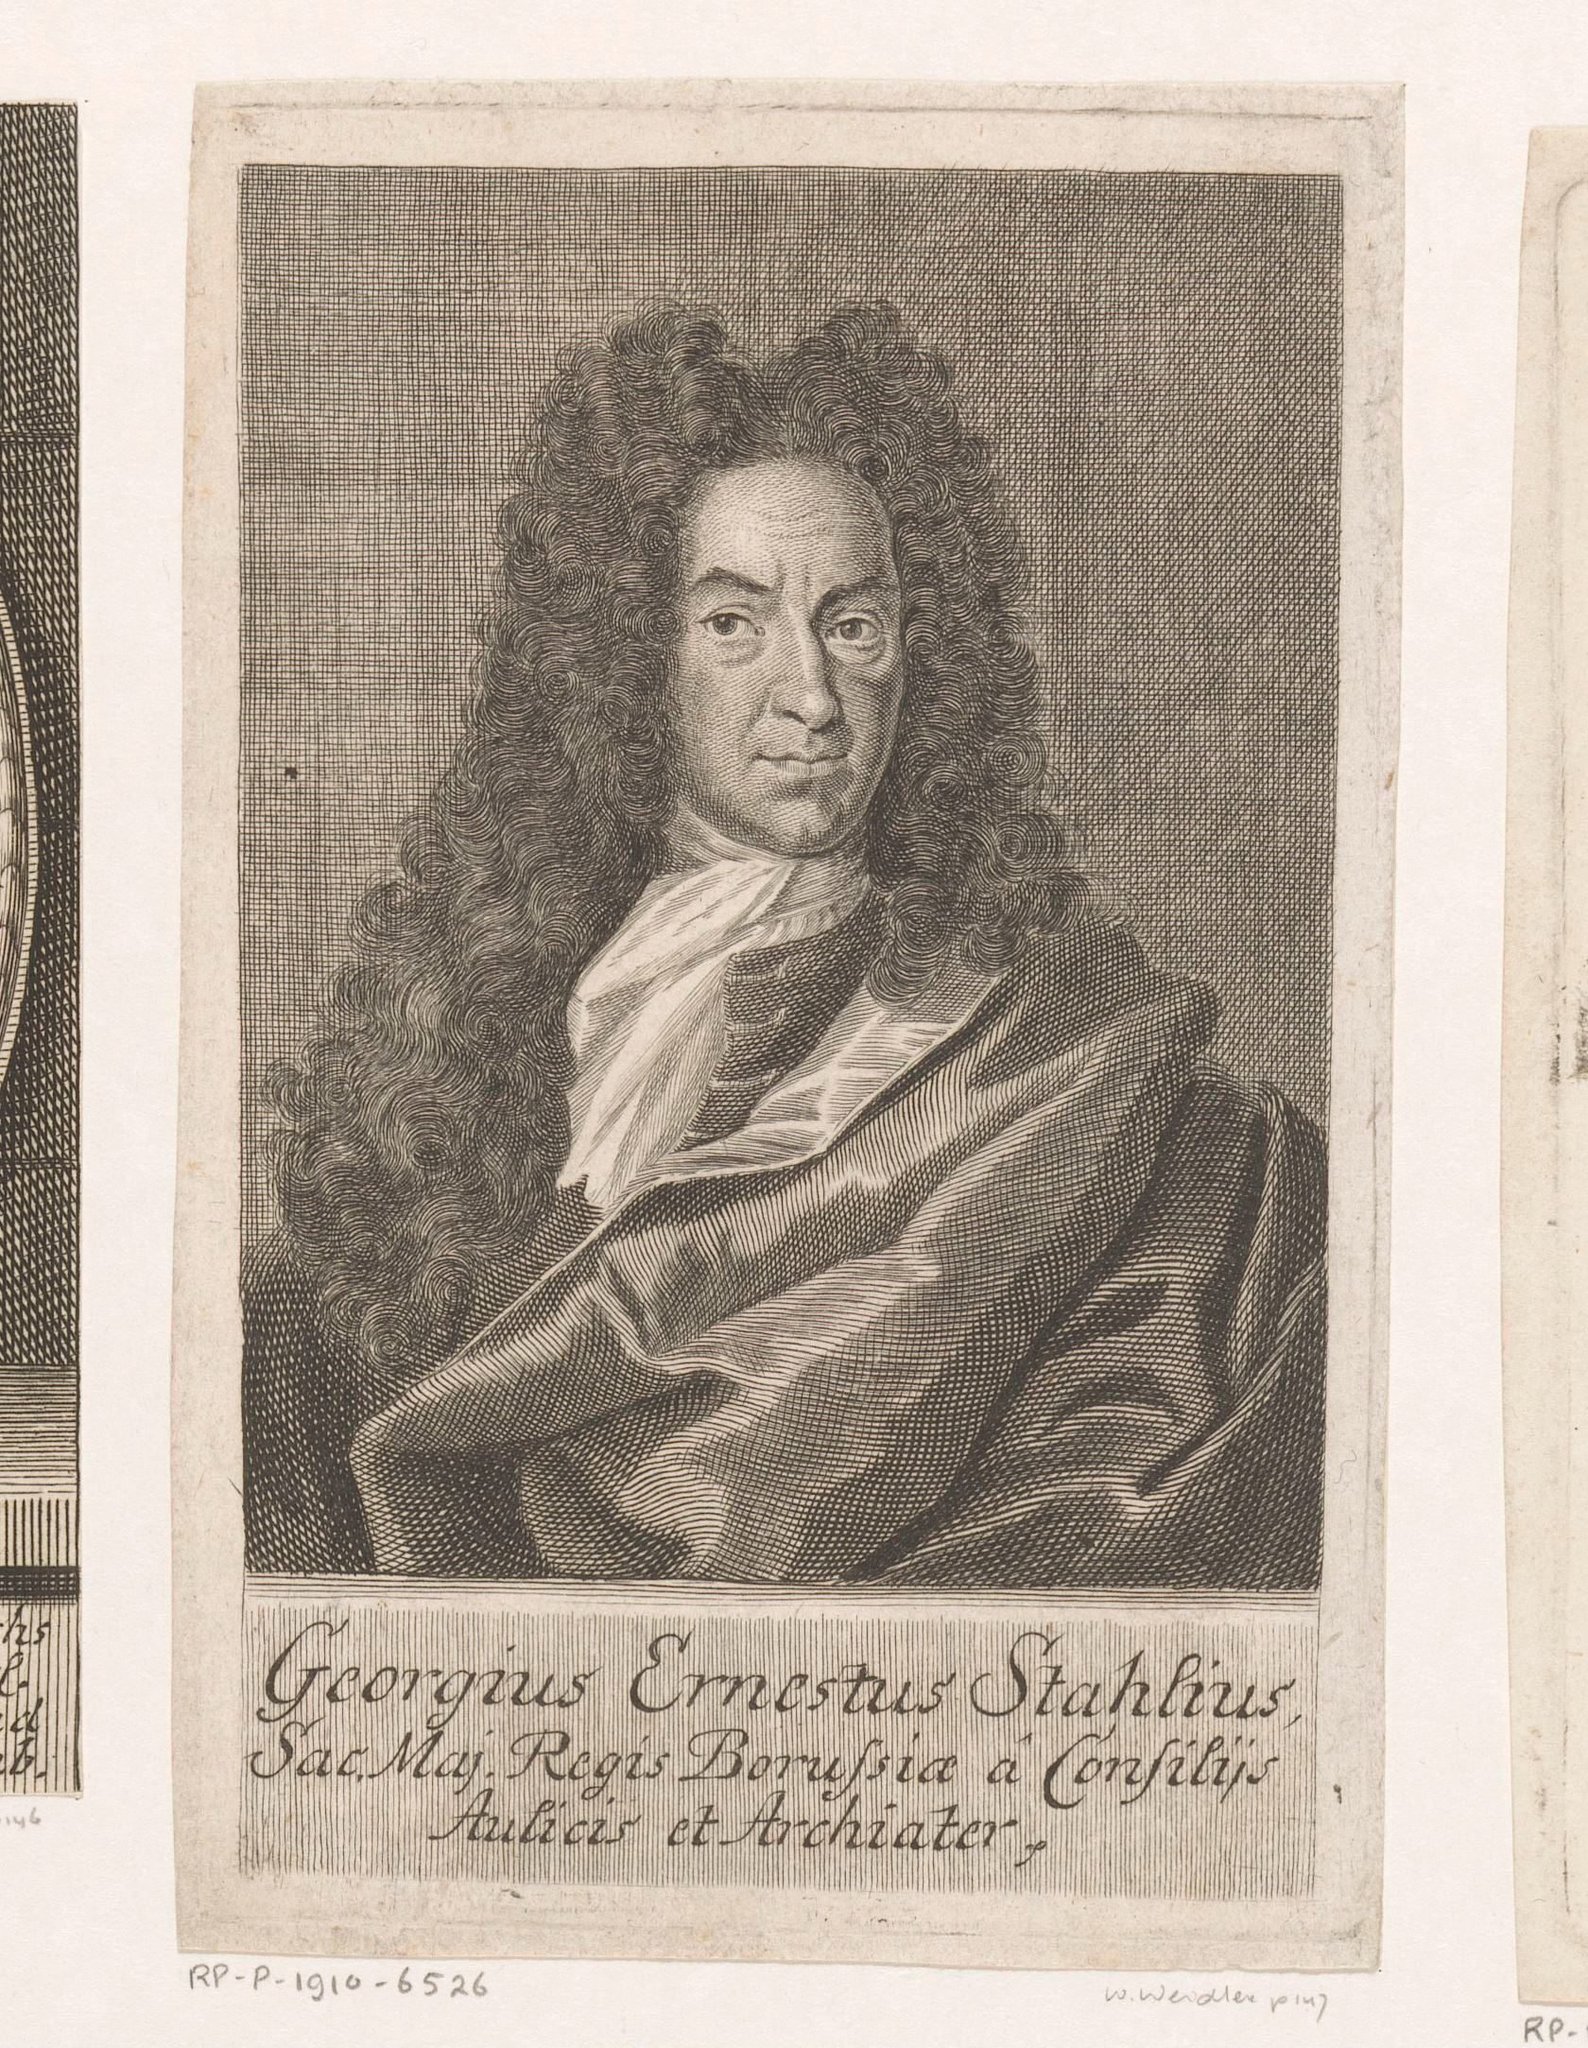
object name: print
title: Portret van Georg Ernst Stahl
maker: martin bernigeroth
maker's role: print maker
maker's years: 1670-1733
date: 1726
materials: paper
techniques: engraving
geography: leipzig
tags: berlin, historical persons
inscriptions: collector's mark: Lugt 2228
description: Prent ook gebruikt in: Deutsche Acta Eruditorum (...). dl. 117. Leipzig: Johann Gottlieb Gleditsch, 1726.